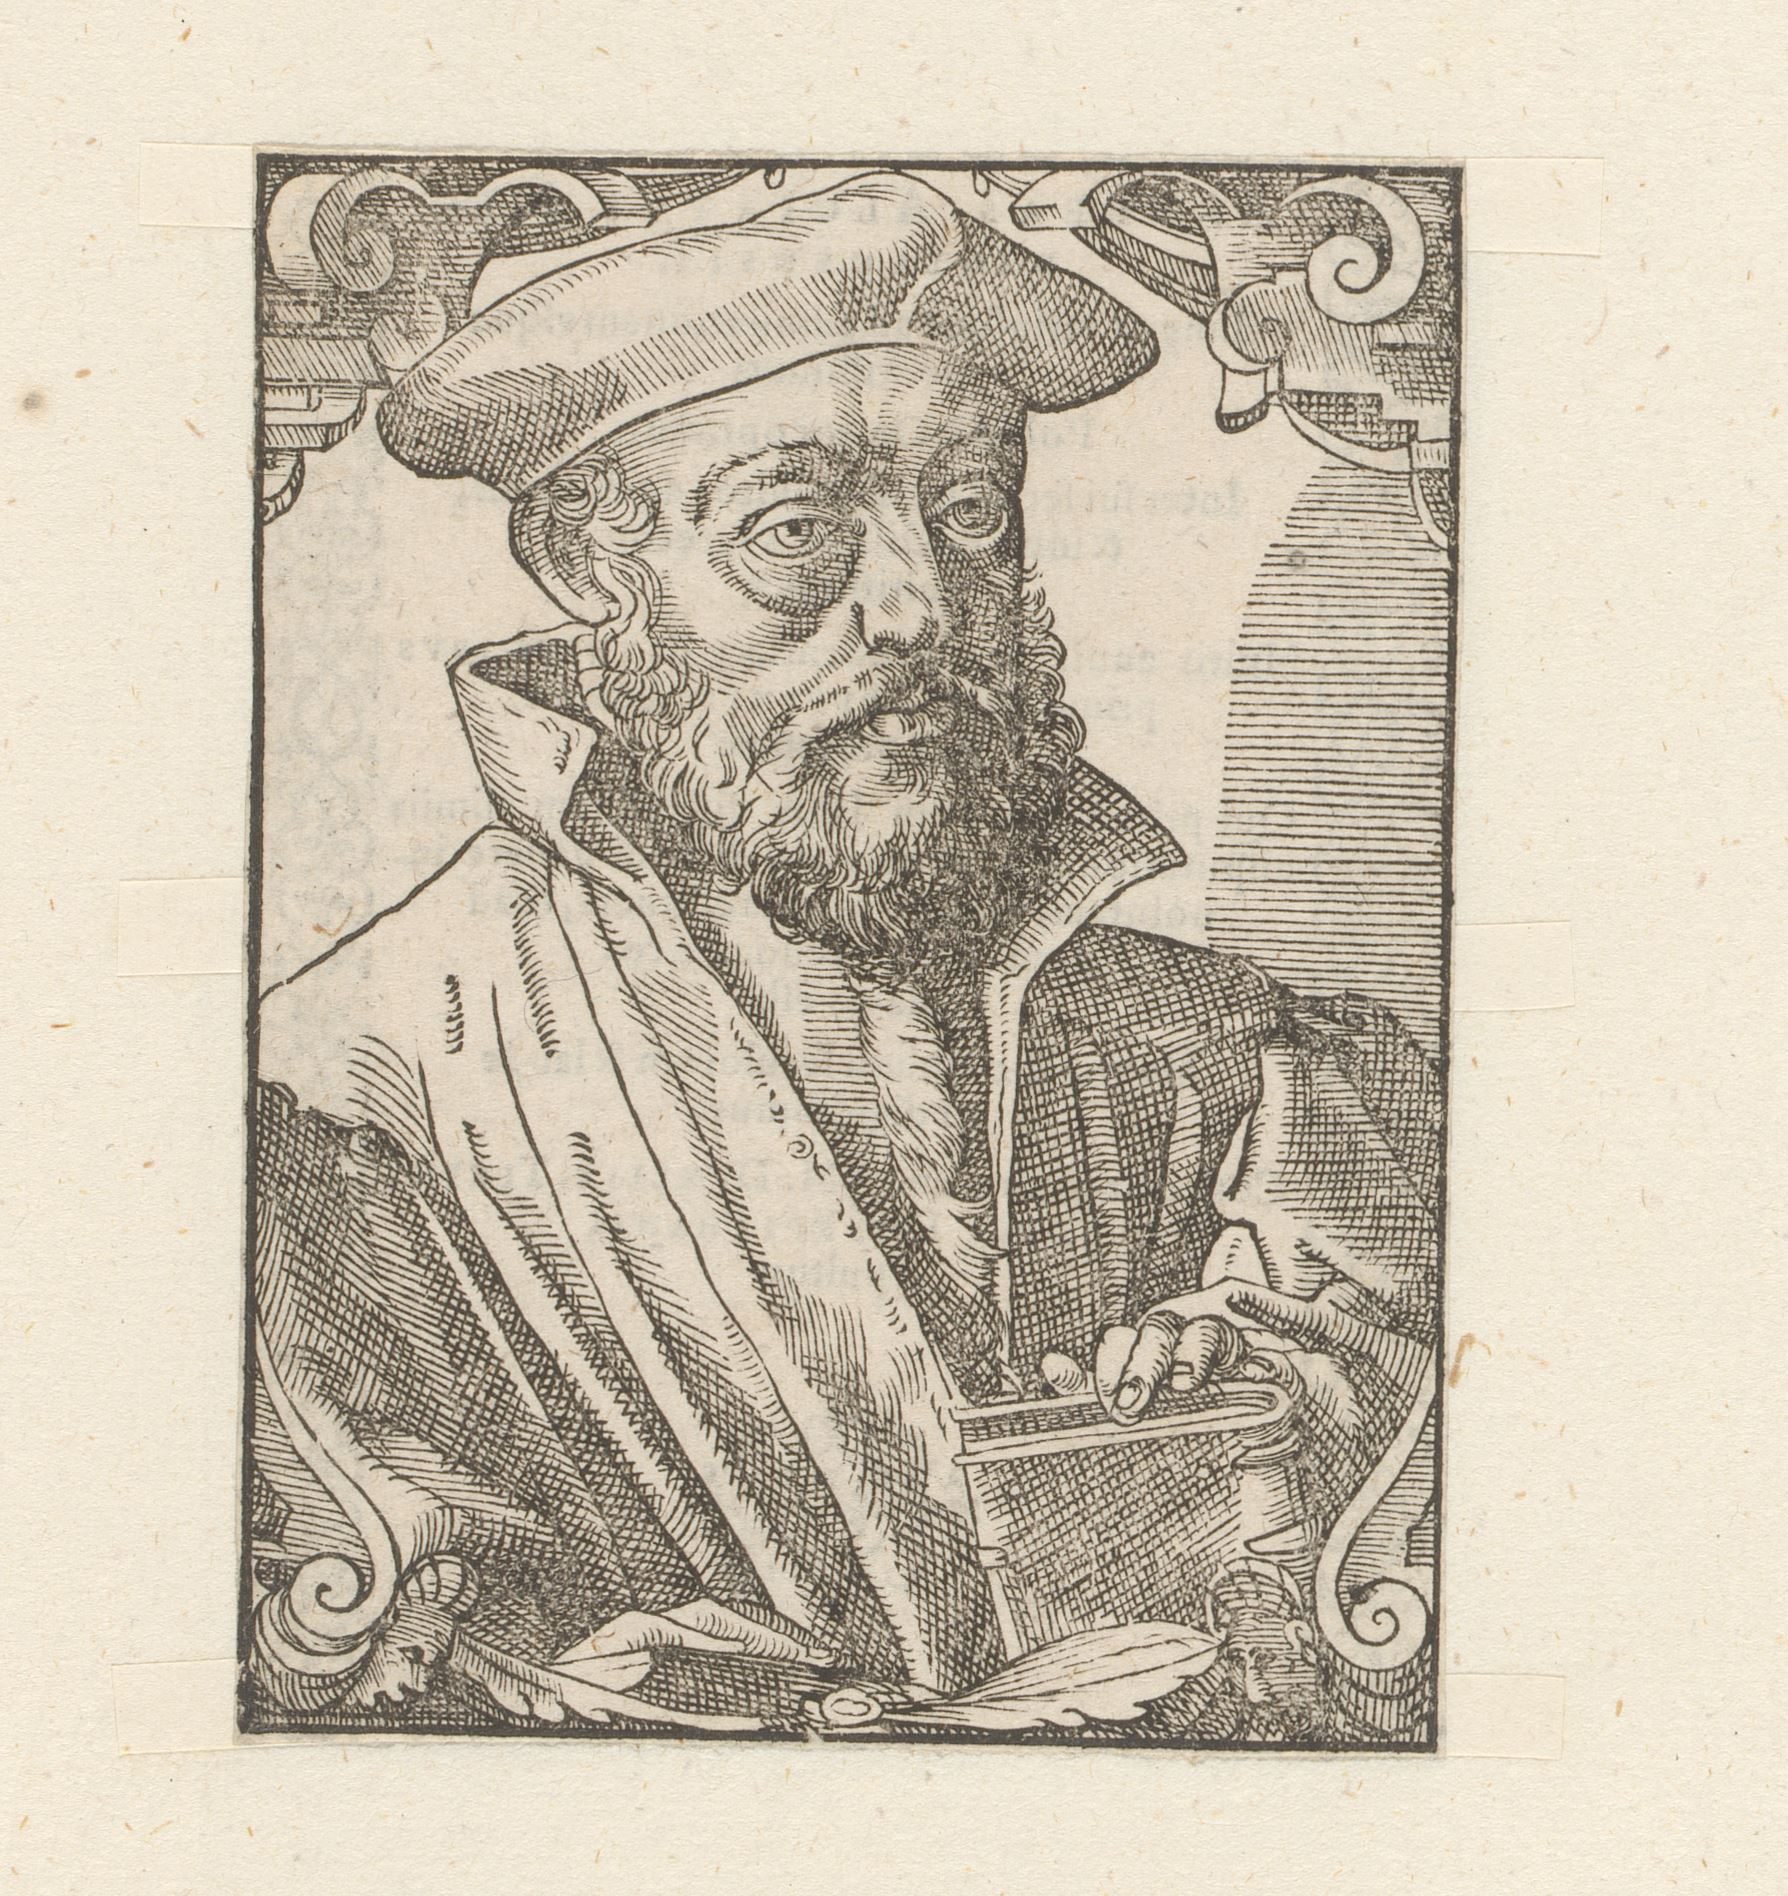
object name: book illustration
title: Portret van Andrea Alciato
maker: Anonymous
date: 1549-1584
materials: paper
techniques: letterpress printing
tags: andrea alciato, historical persons, lawyer, attorney at law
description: Prent gebruikt in: Reusner, Nikolaus. Icones Sive Imagines Vivae. Bazel: Conrad Waldkirch, 1589.